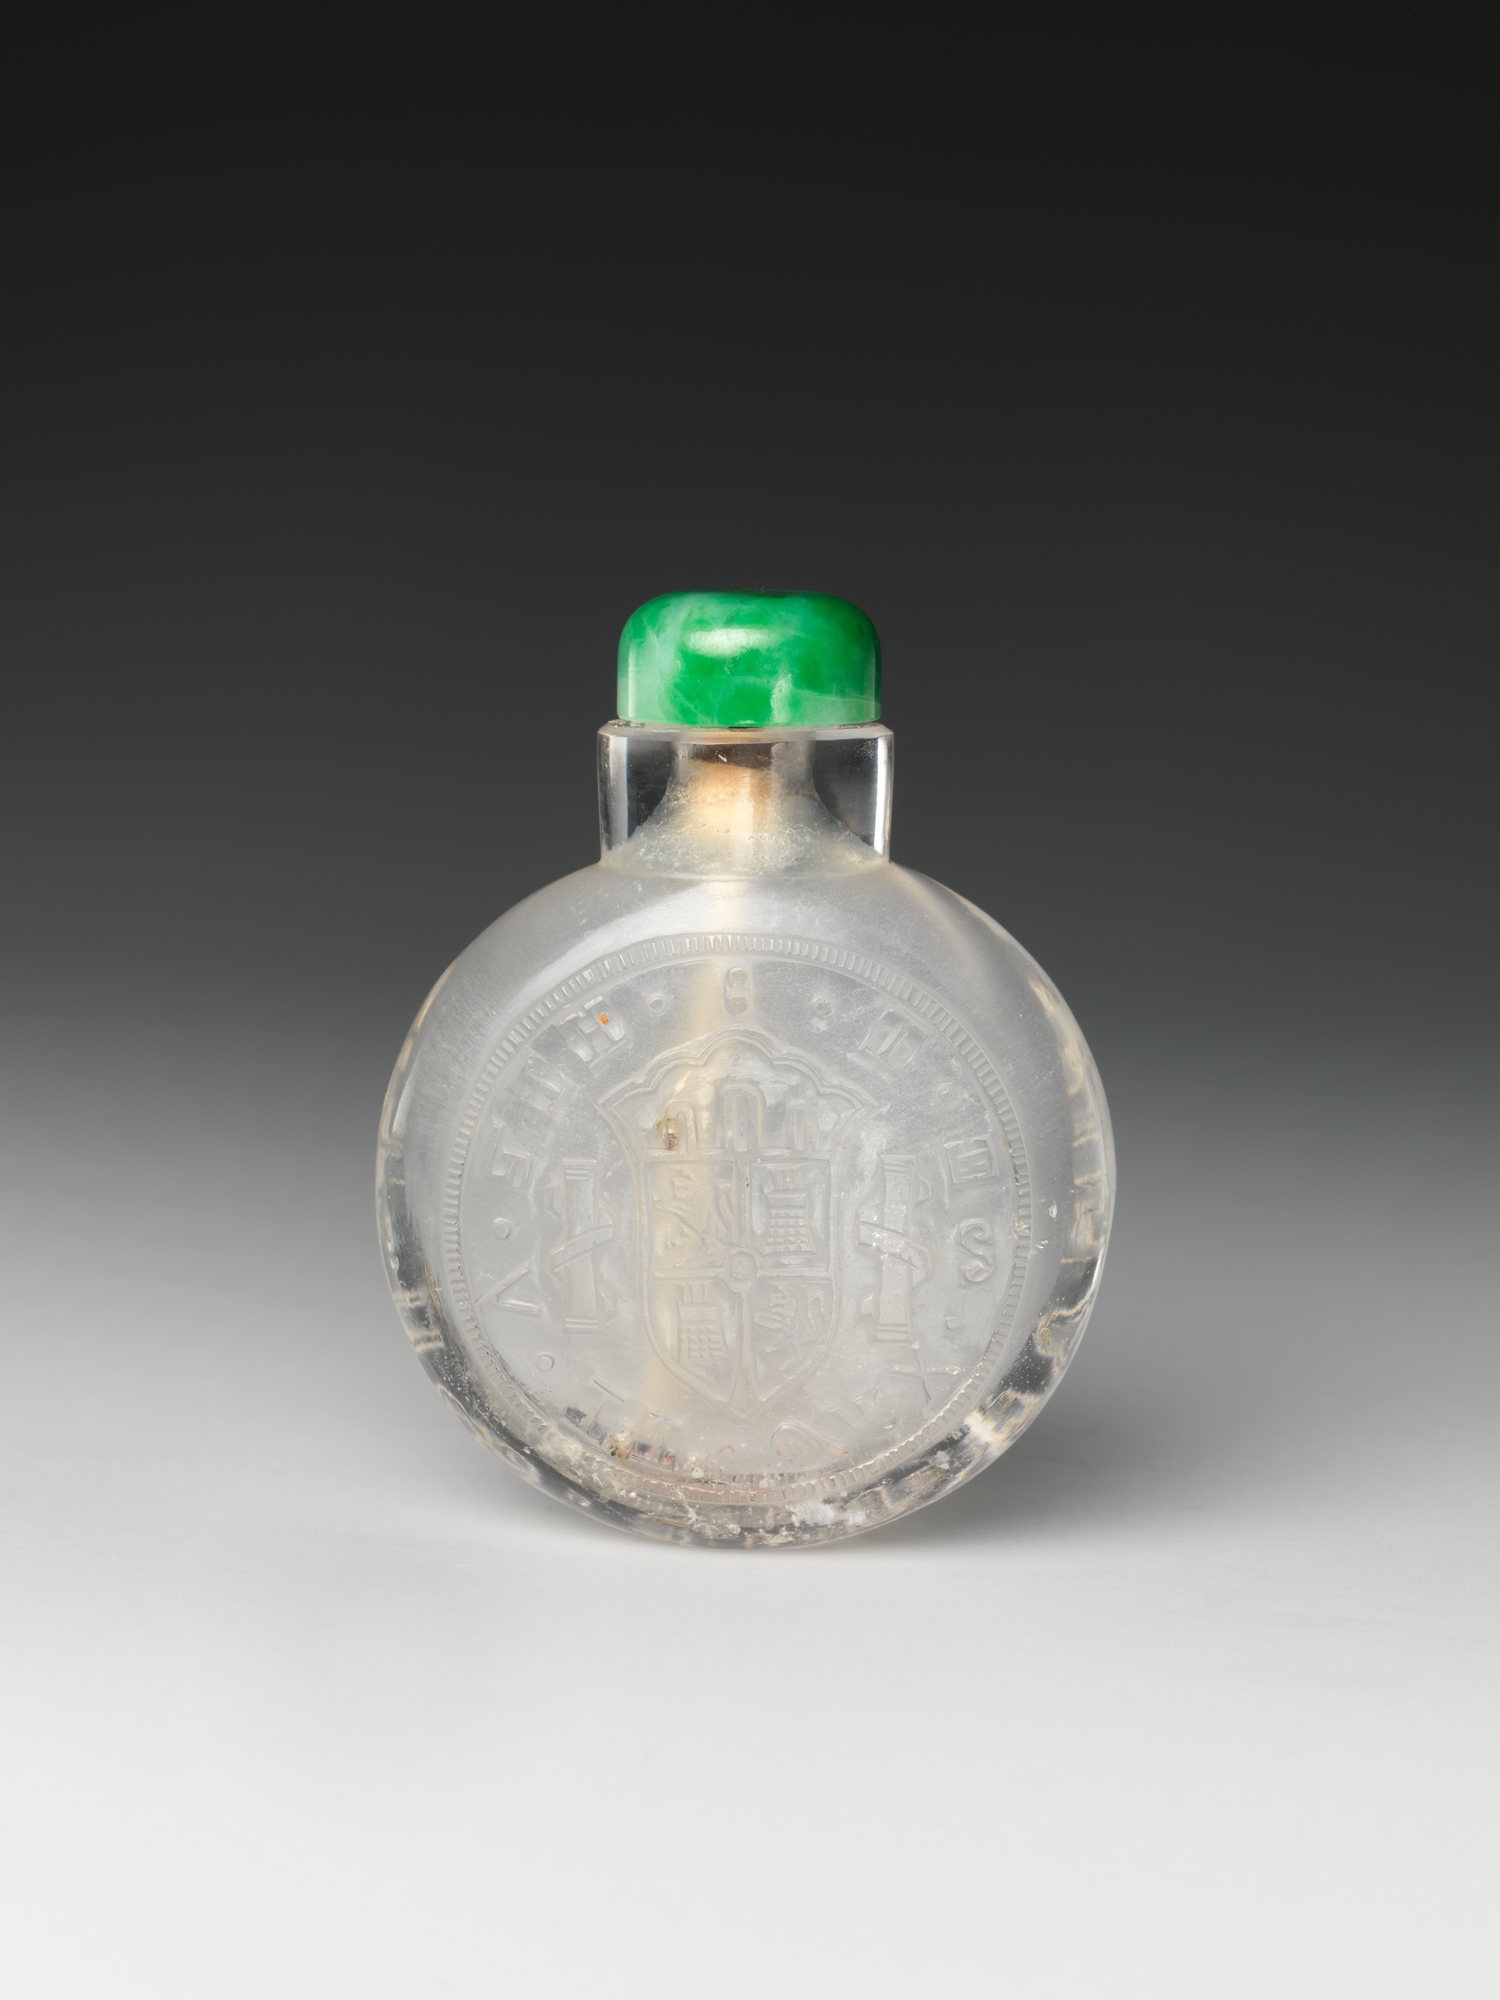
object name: snuff bottle with stopper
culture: chinese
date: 1701-1900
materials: quartz